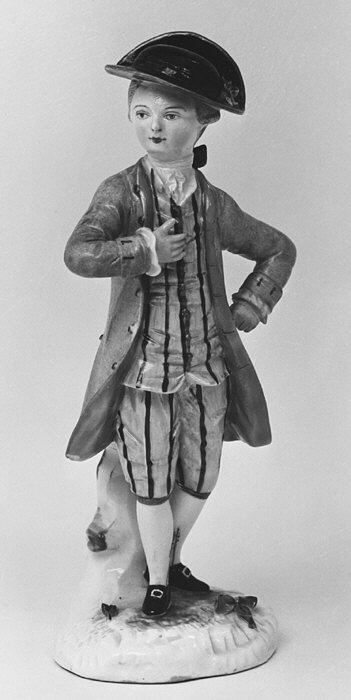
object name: figure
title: Boy (one of a pair)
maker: fulda pottery and porcelain manufactory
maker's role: manufactory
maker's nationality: german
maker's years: 1764-1789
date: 1770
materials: hard paste porcelain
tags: boys